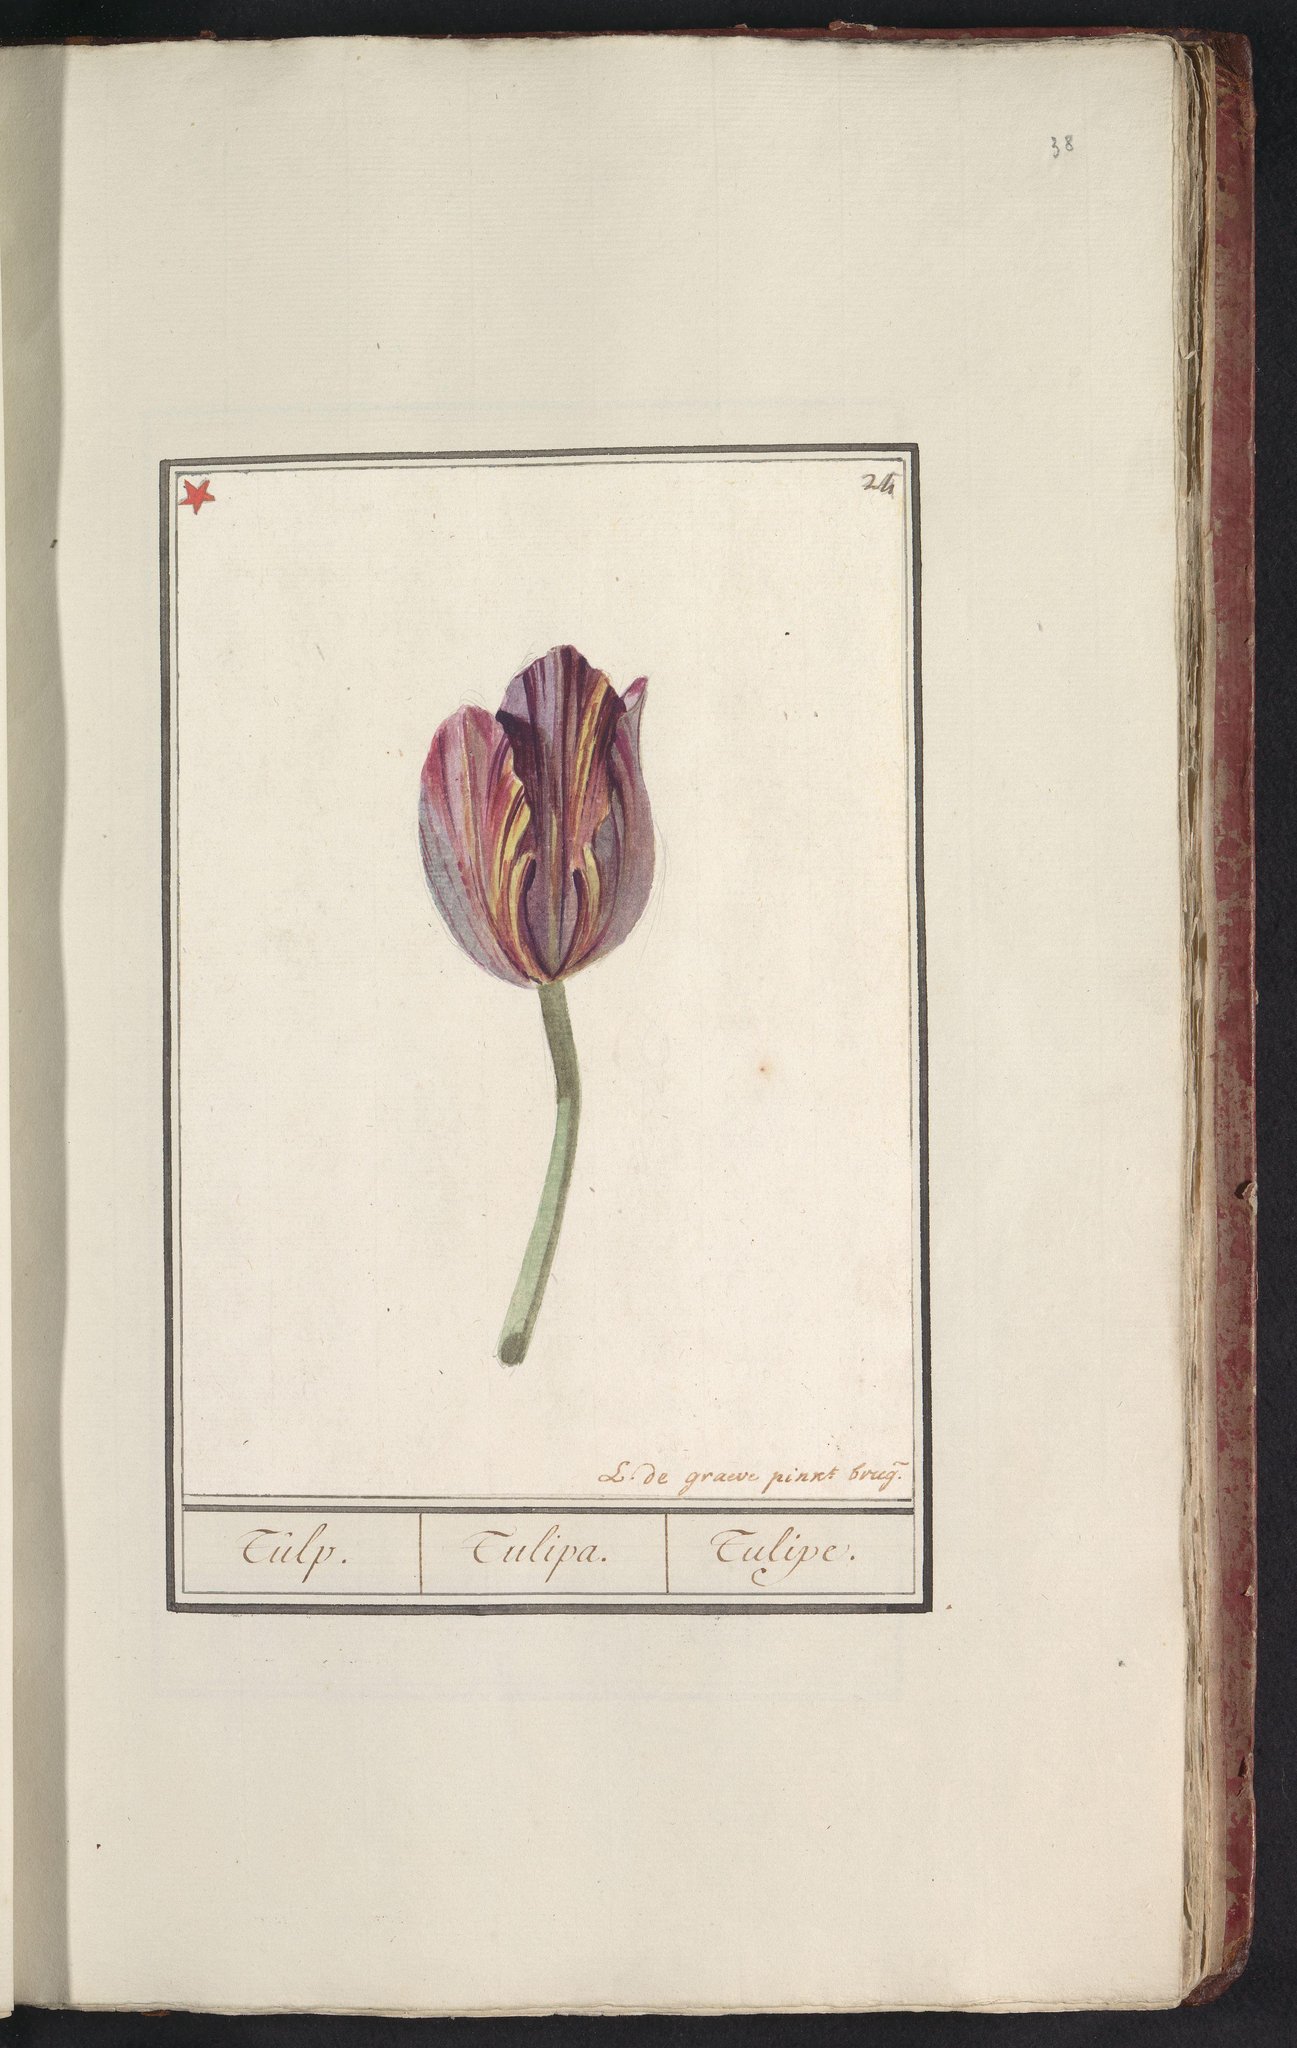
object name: drawing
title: Tulp (Tulipa)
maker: louis de graeve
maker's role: draughtsman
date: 1790-1814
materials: paint, paper, pencil, watercolor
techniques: brush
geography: bruges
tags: flowers: tulip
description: Donkerrood-gele tulp. Genummerd rechtsboven: 24. Linksboven gemerkt met een rood sterretje. Onderdeel van het eerste album met tekeningen van bloemen en planten. Achtste van twaalf albums met tekeningen van dieren, vogels en planten bekend rond 1600, gemaakt in opdracht van keizer Rudolf II. Met toelichting in Nederlands, Latijn en Frans.